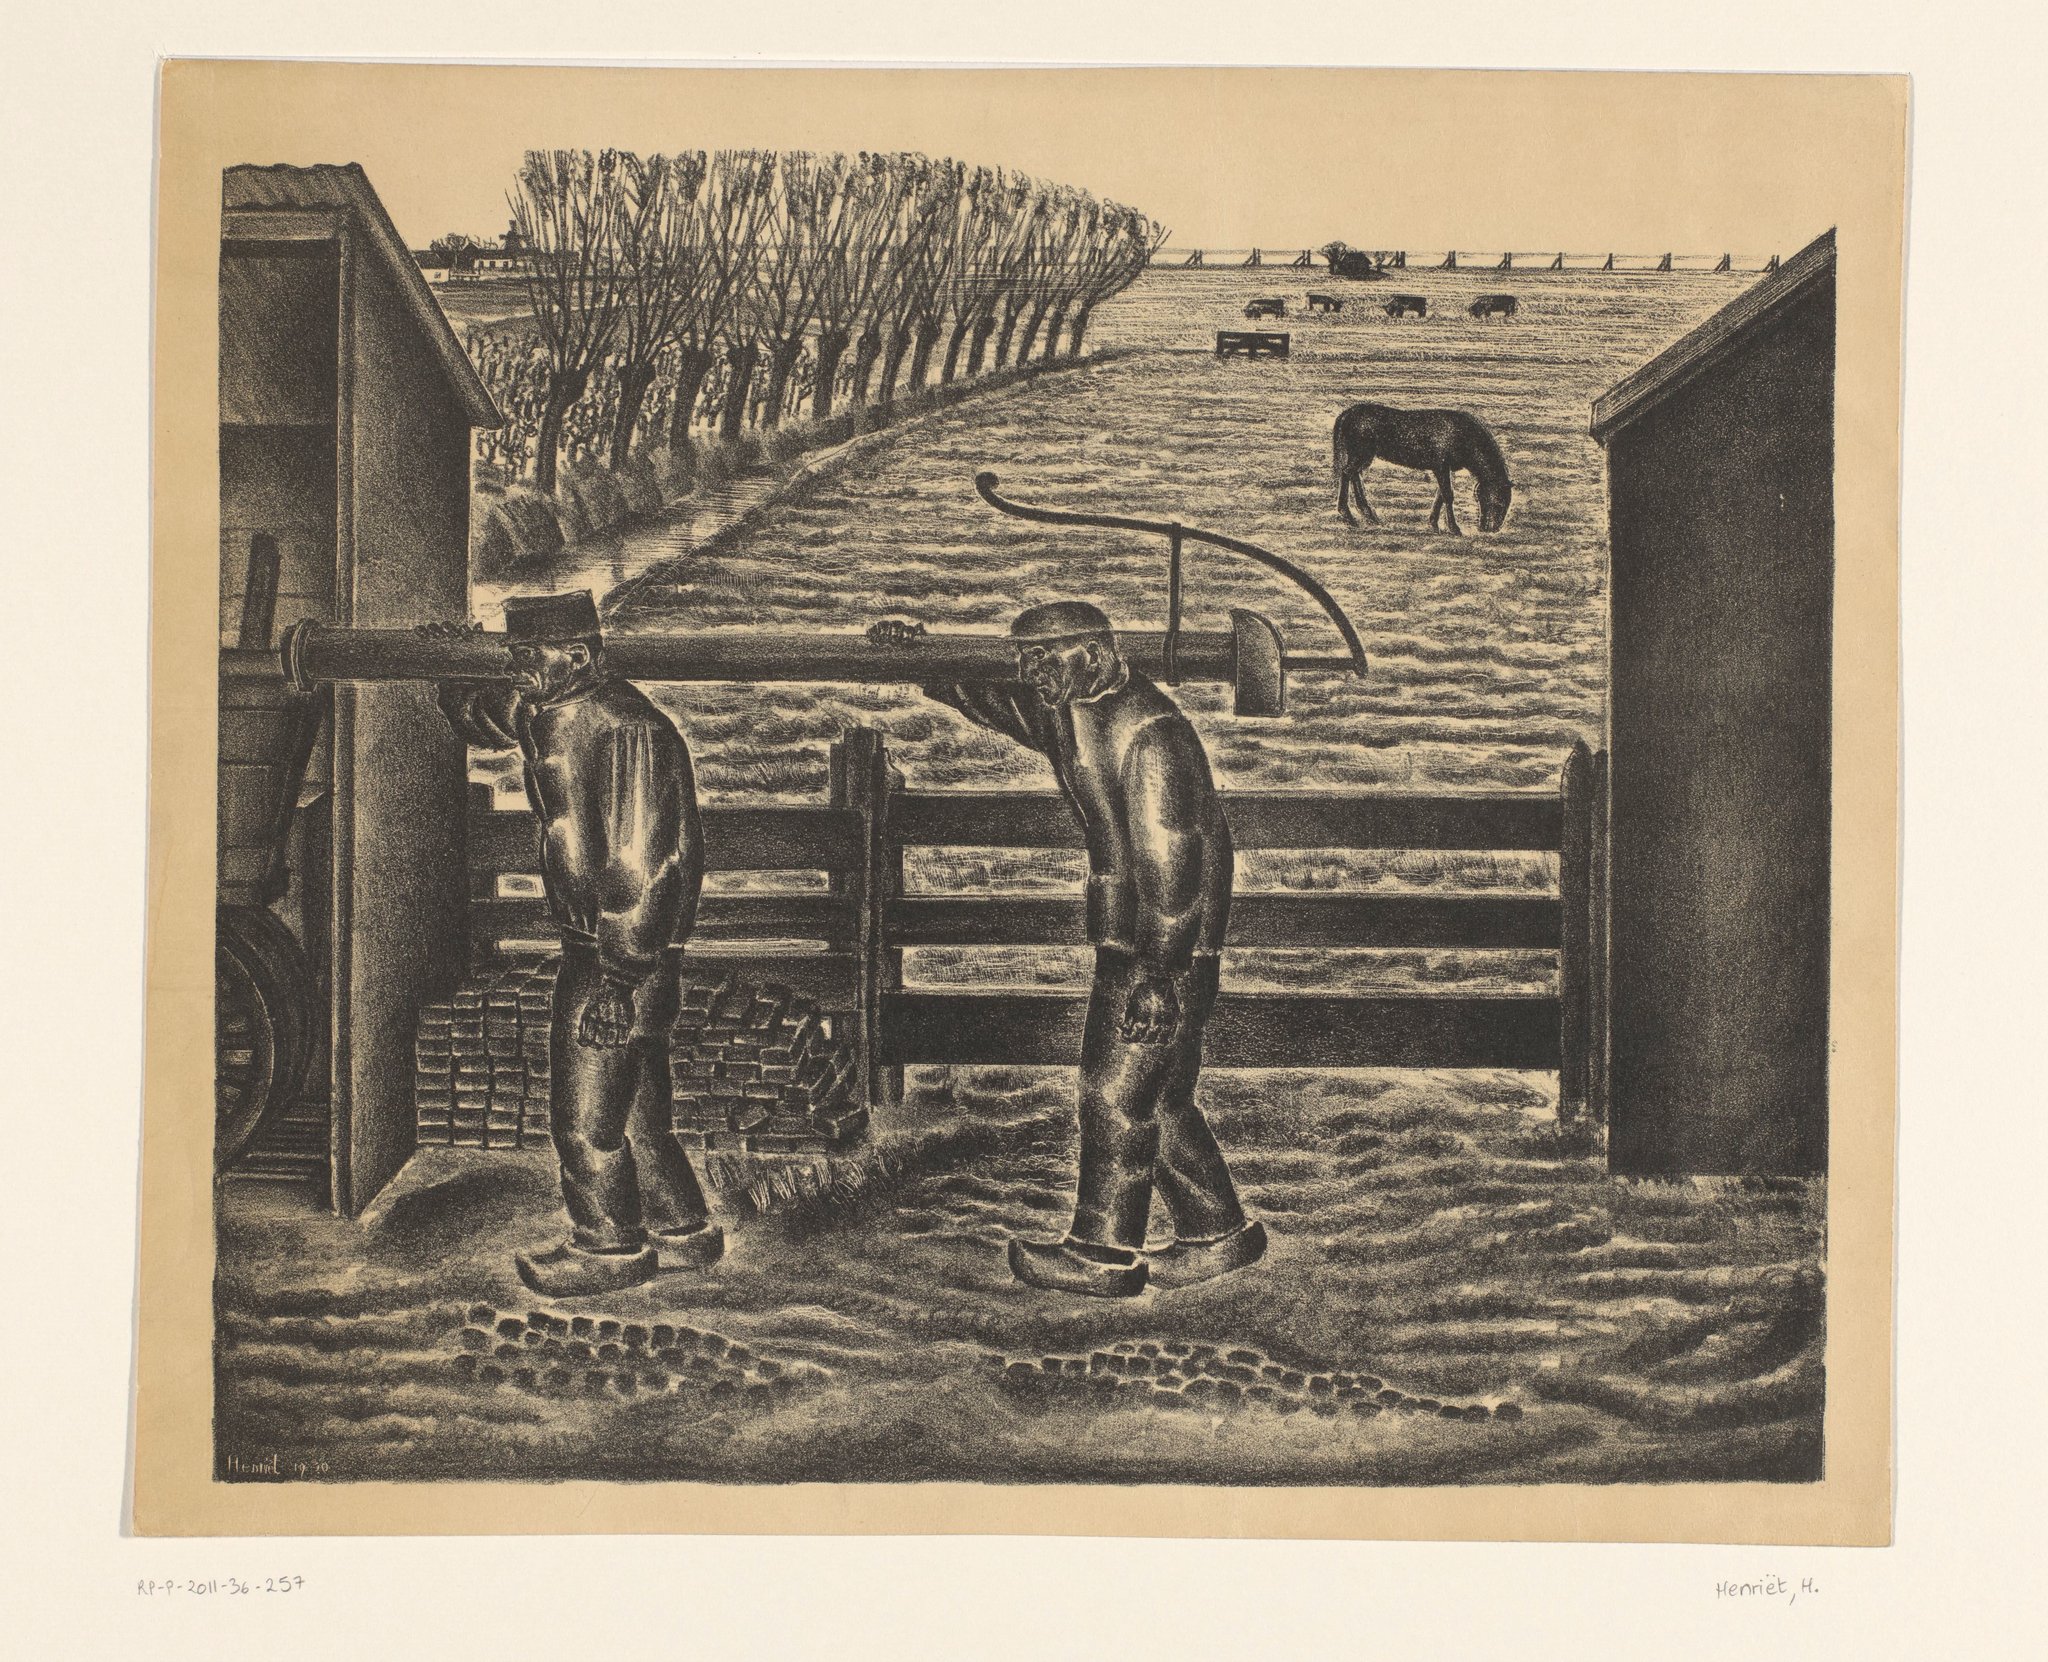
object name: print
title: Twee boeren in een landschap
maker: henk henriët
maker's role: draughtsman, print maker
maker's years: 1903-1945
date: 1930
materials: paper, ink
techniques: lithograph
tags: farmers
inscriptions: signature and date: ‘Henriët 1930’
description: Twee boeren die samen de buis van een waterpomp dragen, met op achtergrond grazend vee en wilgen langs een sloot.